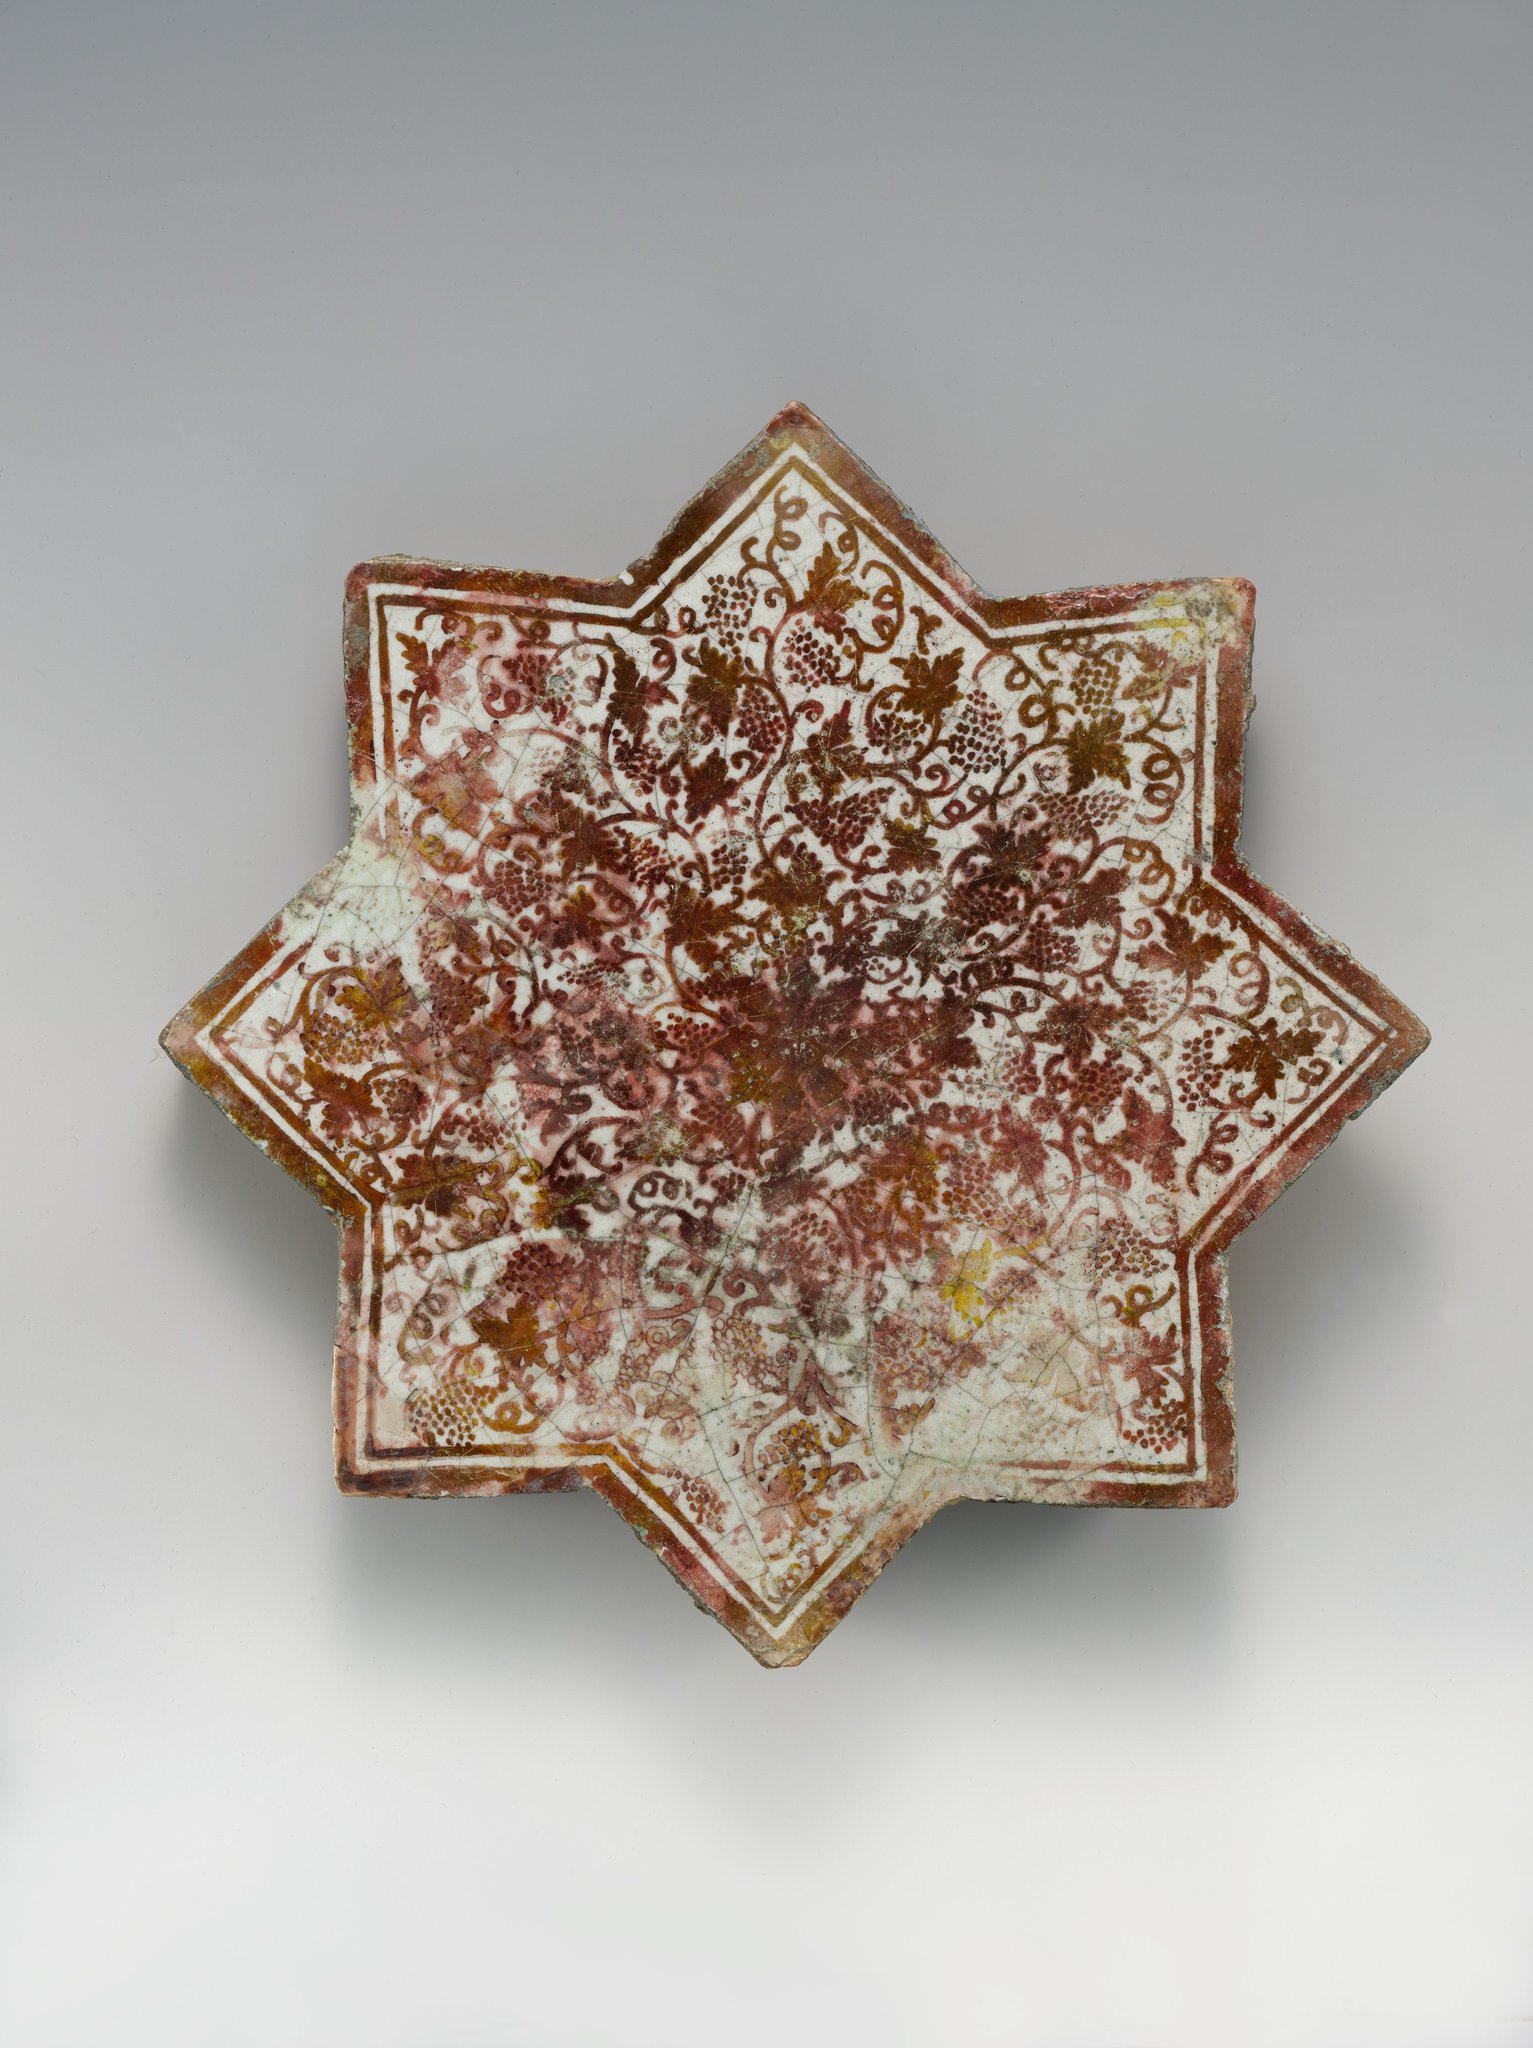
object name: tile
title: Star-Shaped Tile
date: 1401-1450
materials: earthenware, glaze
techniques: luster painting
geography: spain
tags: leaves